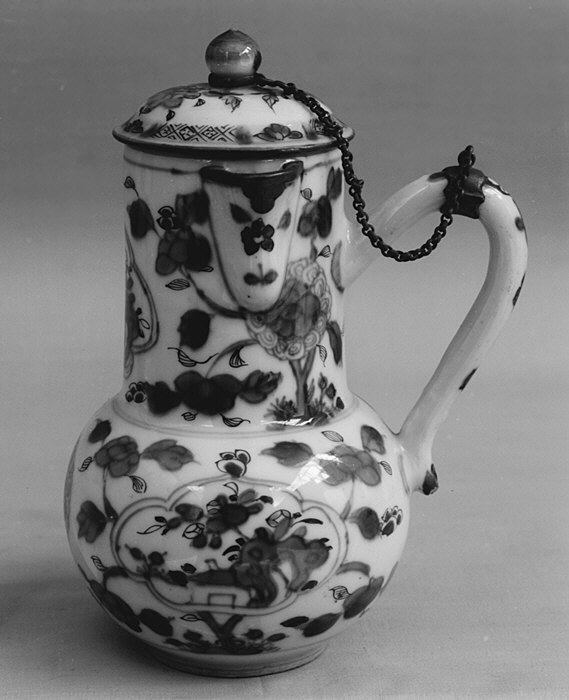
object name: jug with cover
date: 1720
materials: hard paste porcelain, silver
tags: flowers